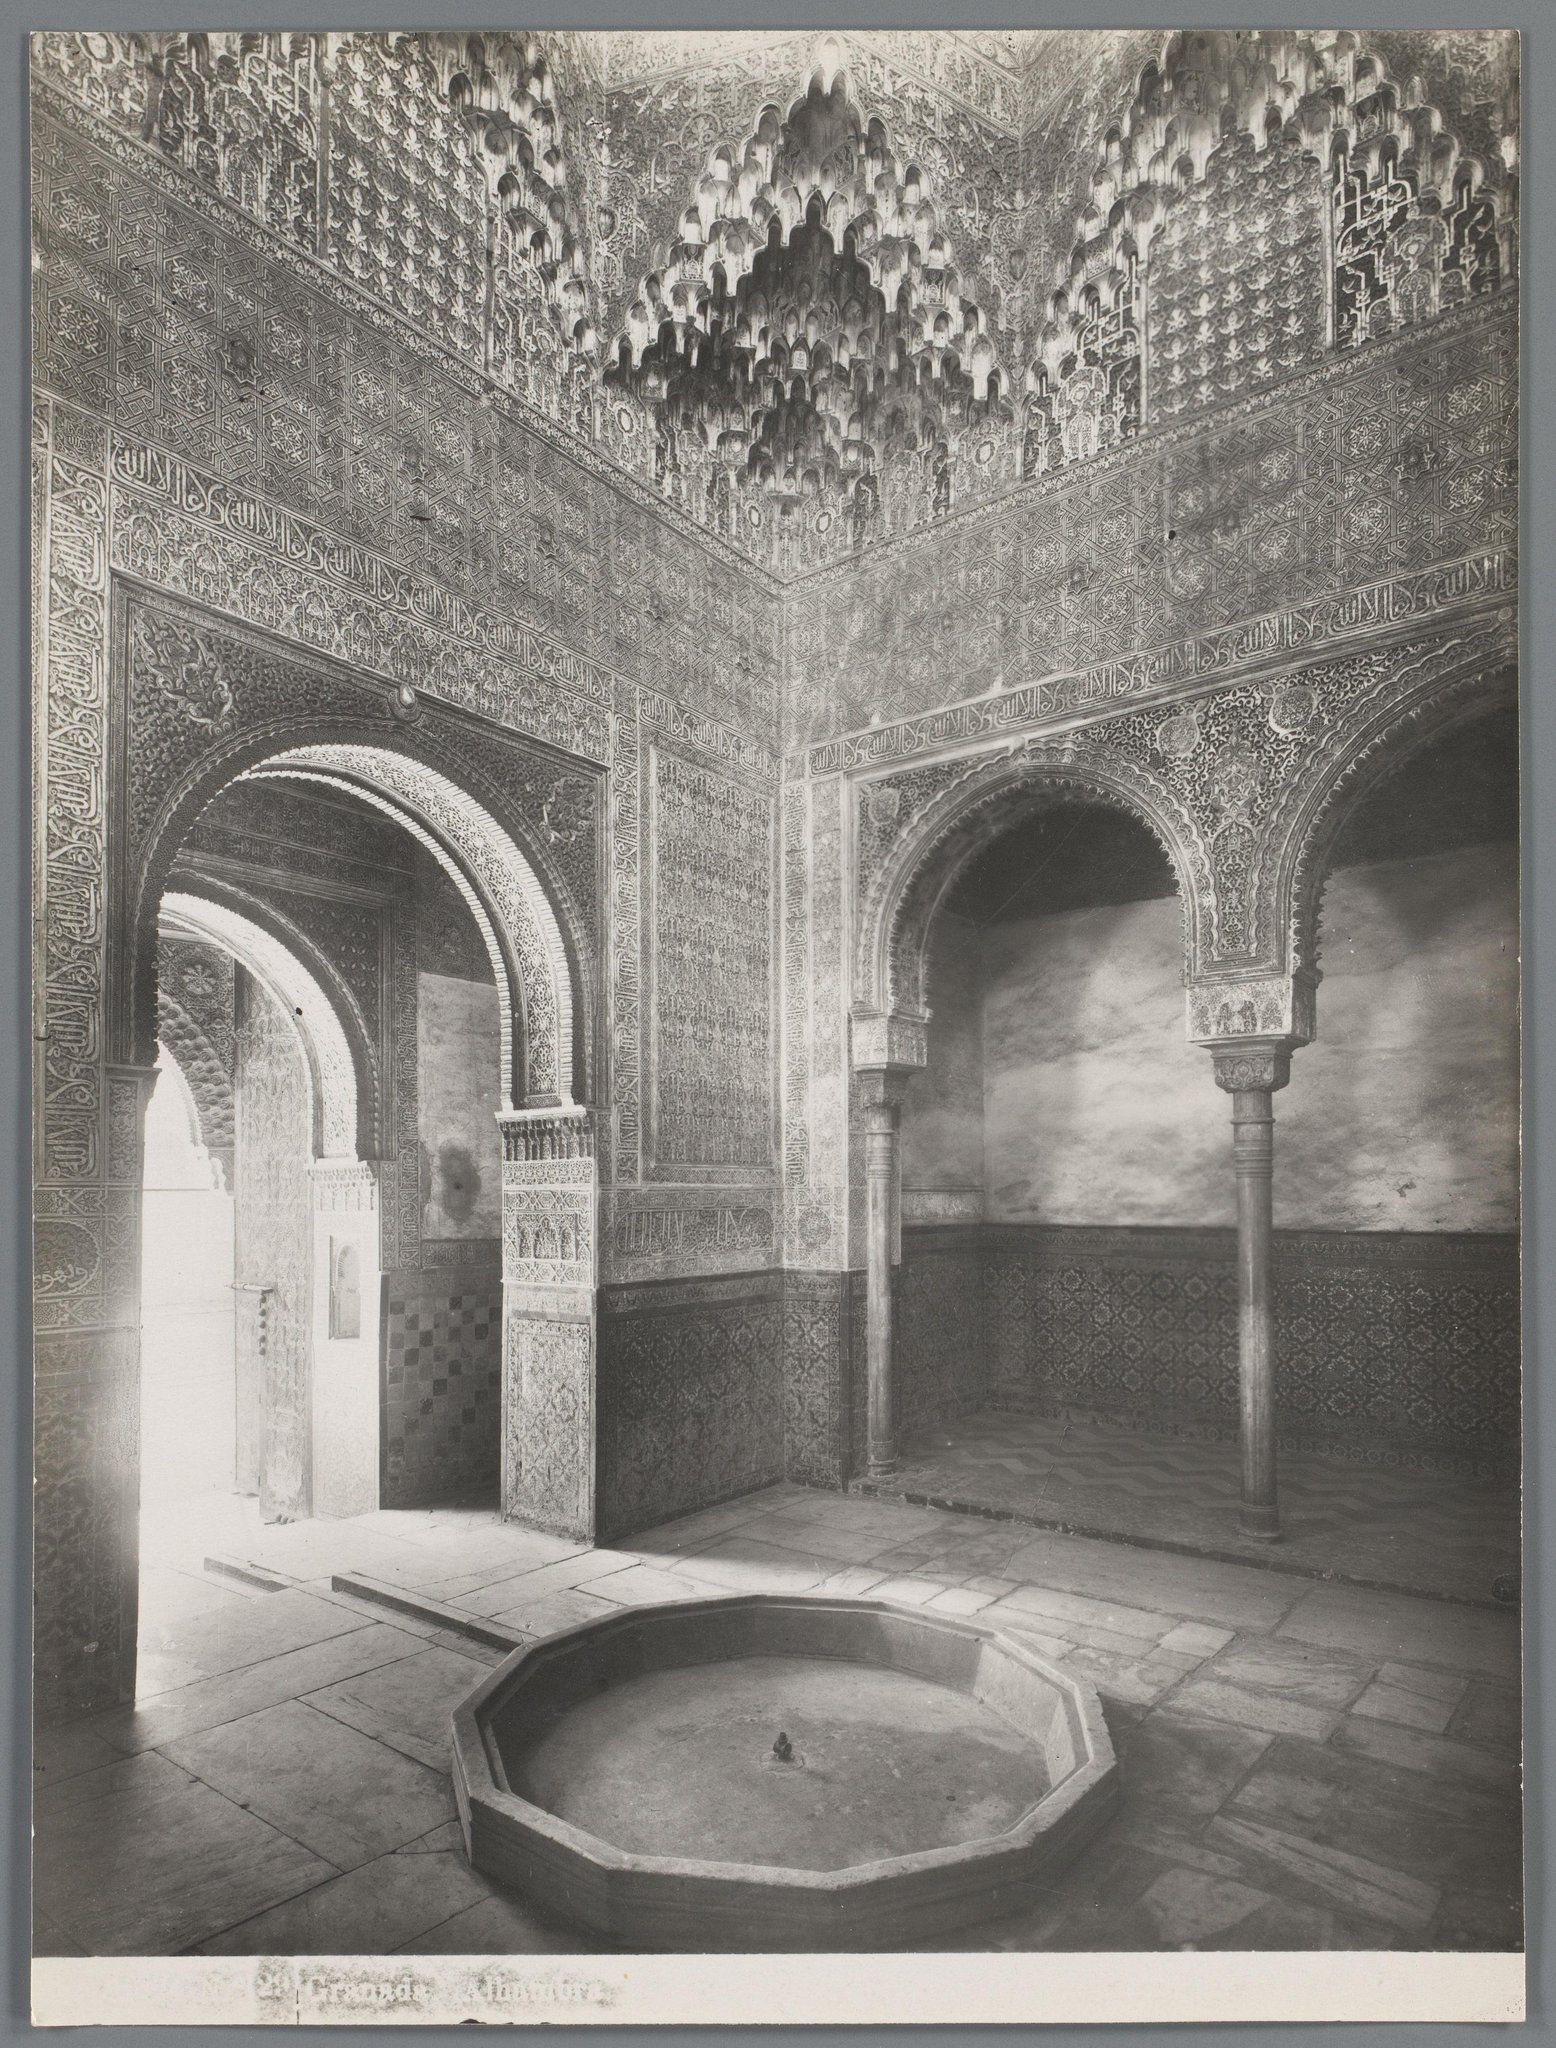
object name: photograph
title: Interieur van een ruimte in het Alhambra te Granada, Spanje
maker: f. linares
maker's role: publisher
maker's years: 1870-1937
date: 1914-1937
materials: photographic support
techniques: gelatin silver print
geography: alhambra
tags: fortress, palace, stuccoeing, interior ~ representation of a building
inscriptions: number: ‘29’